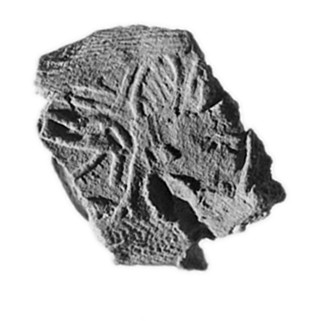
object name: sealing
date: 1981-1640 BCE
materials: mud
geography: egypt